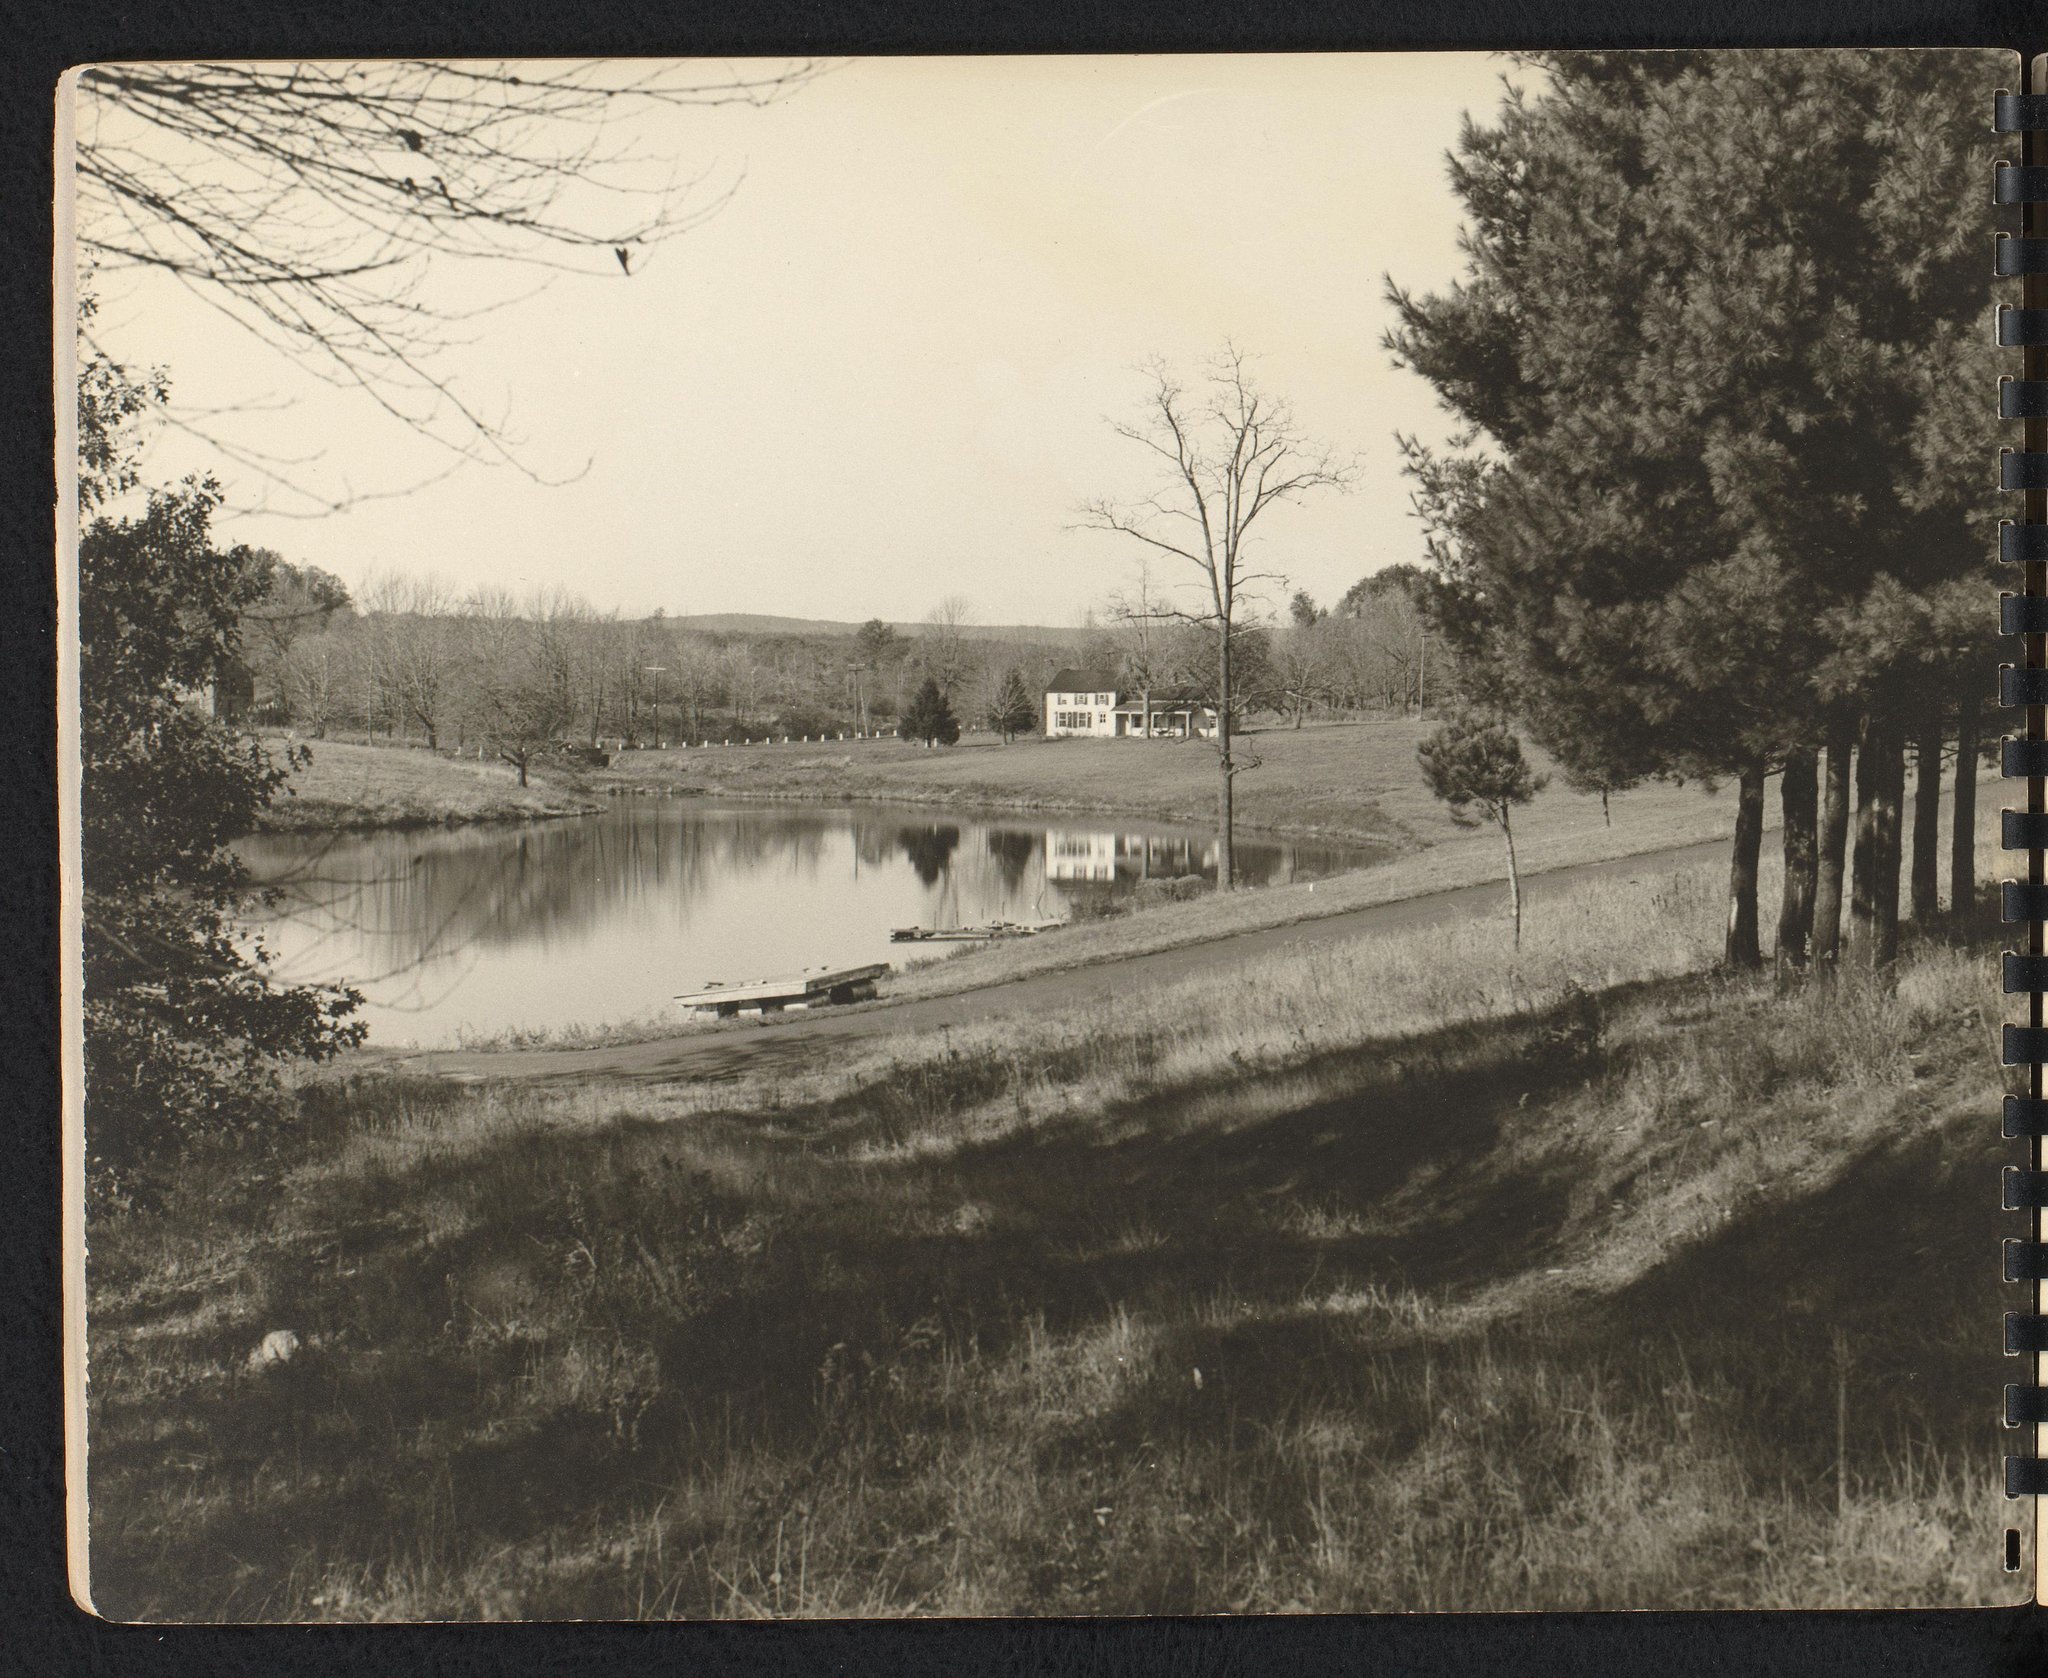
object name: photograph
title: Gezicht over het terrein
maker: Anonymous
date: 1950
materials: paper, photographic support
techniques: gelatin silver print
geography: new york city